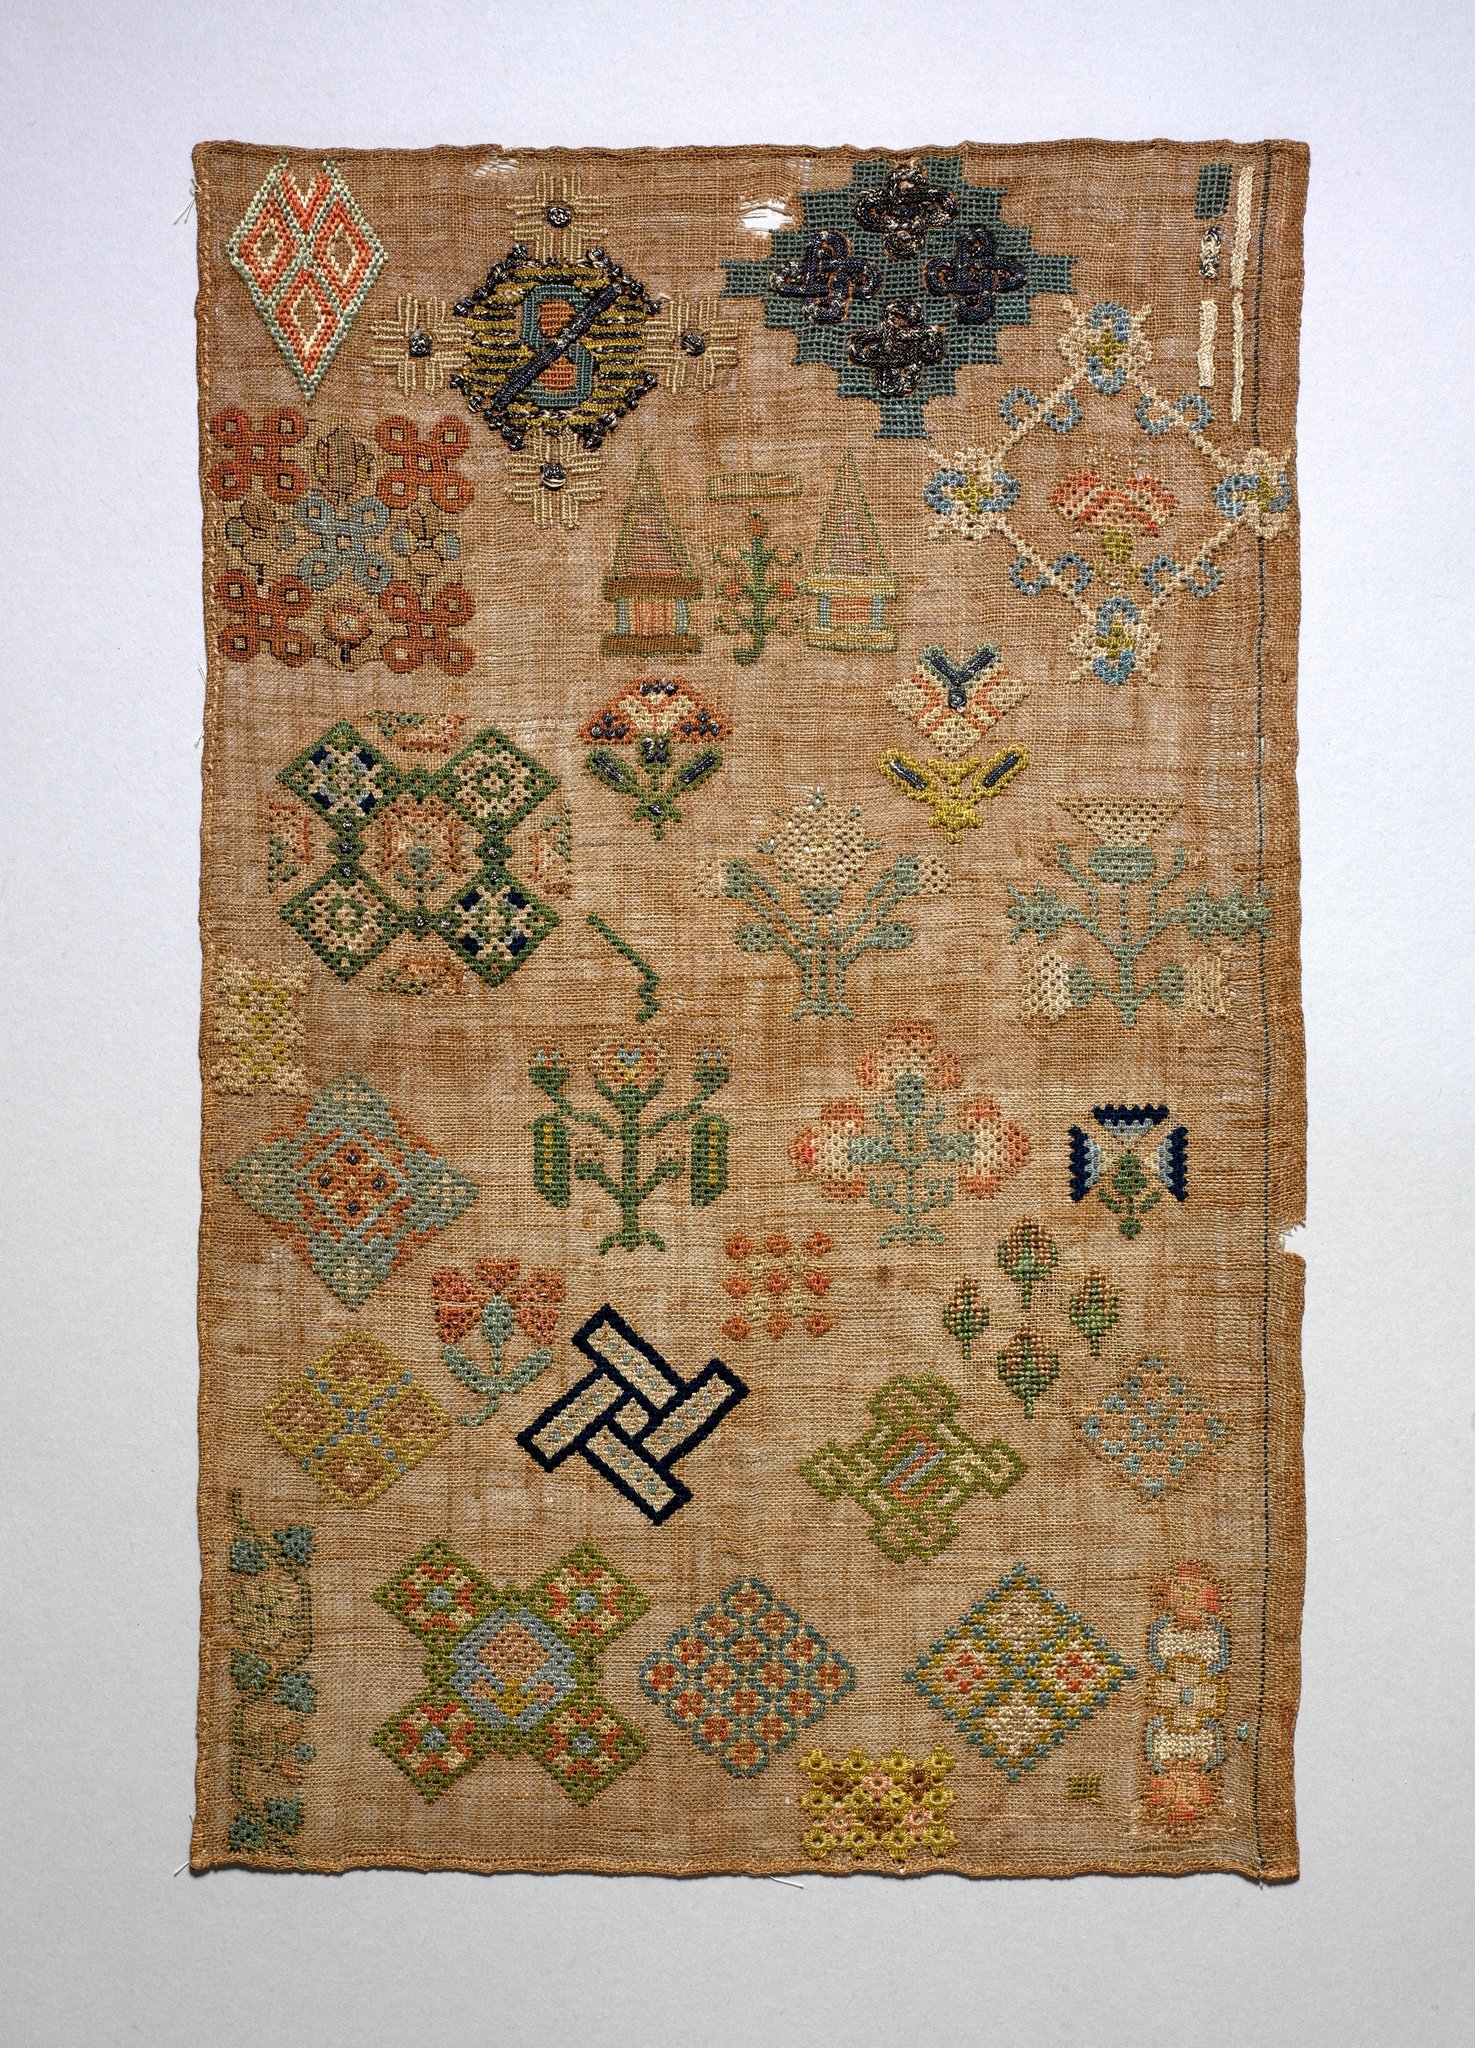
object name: sampler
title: Embroidered spot sampler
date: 1601-1650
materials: canvas, linen, metal thread, silk